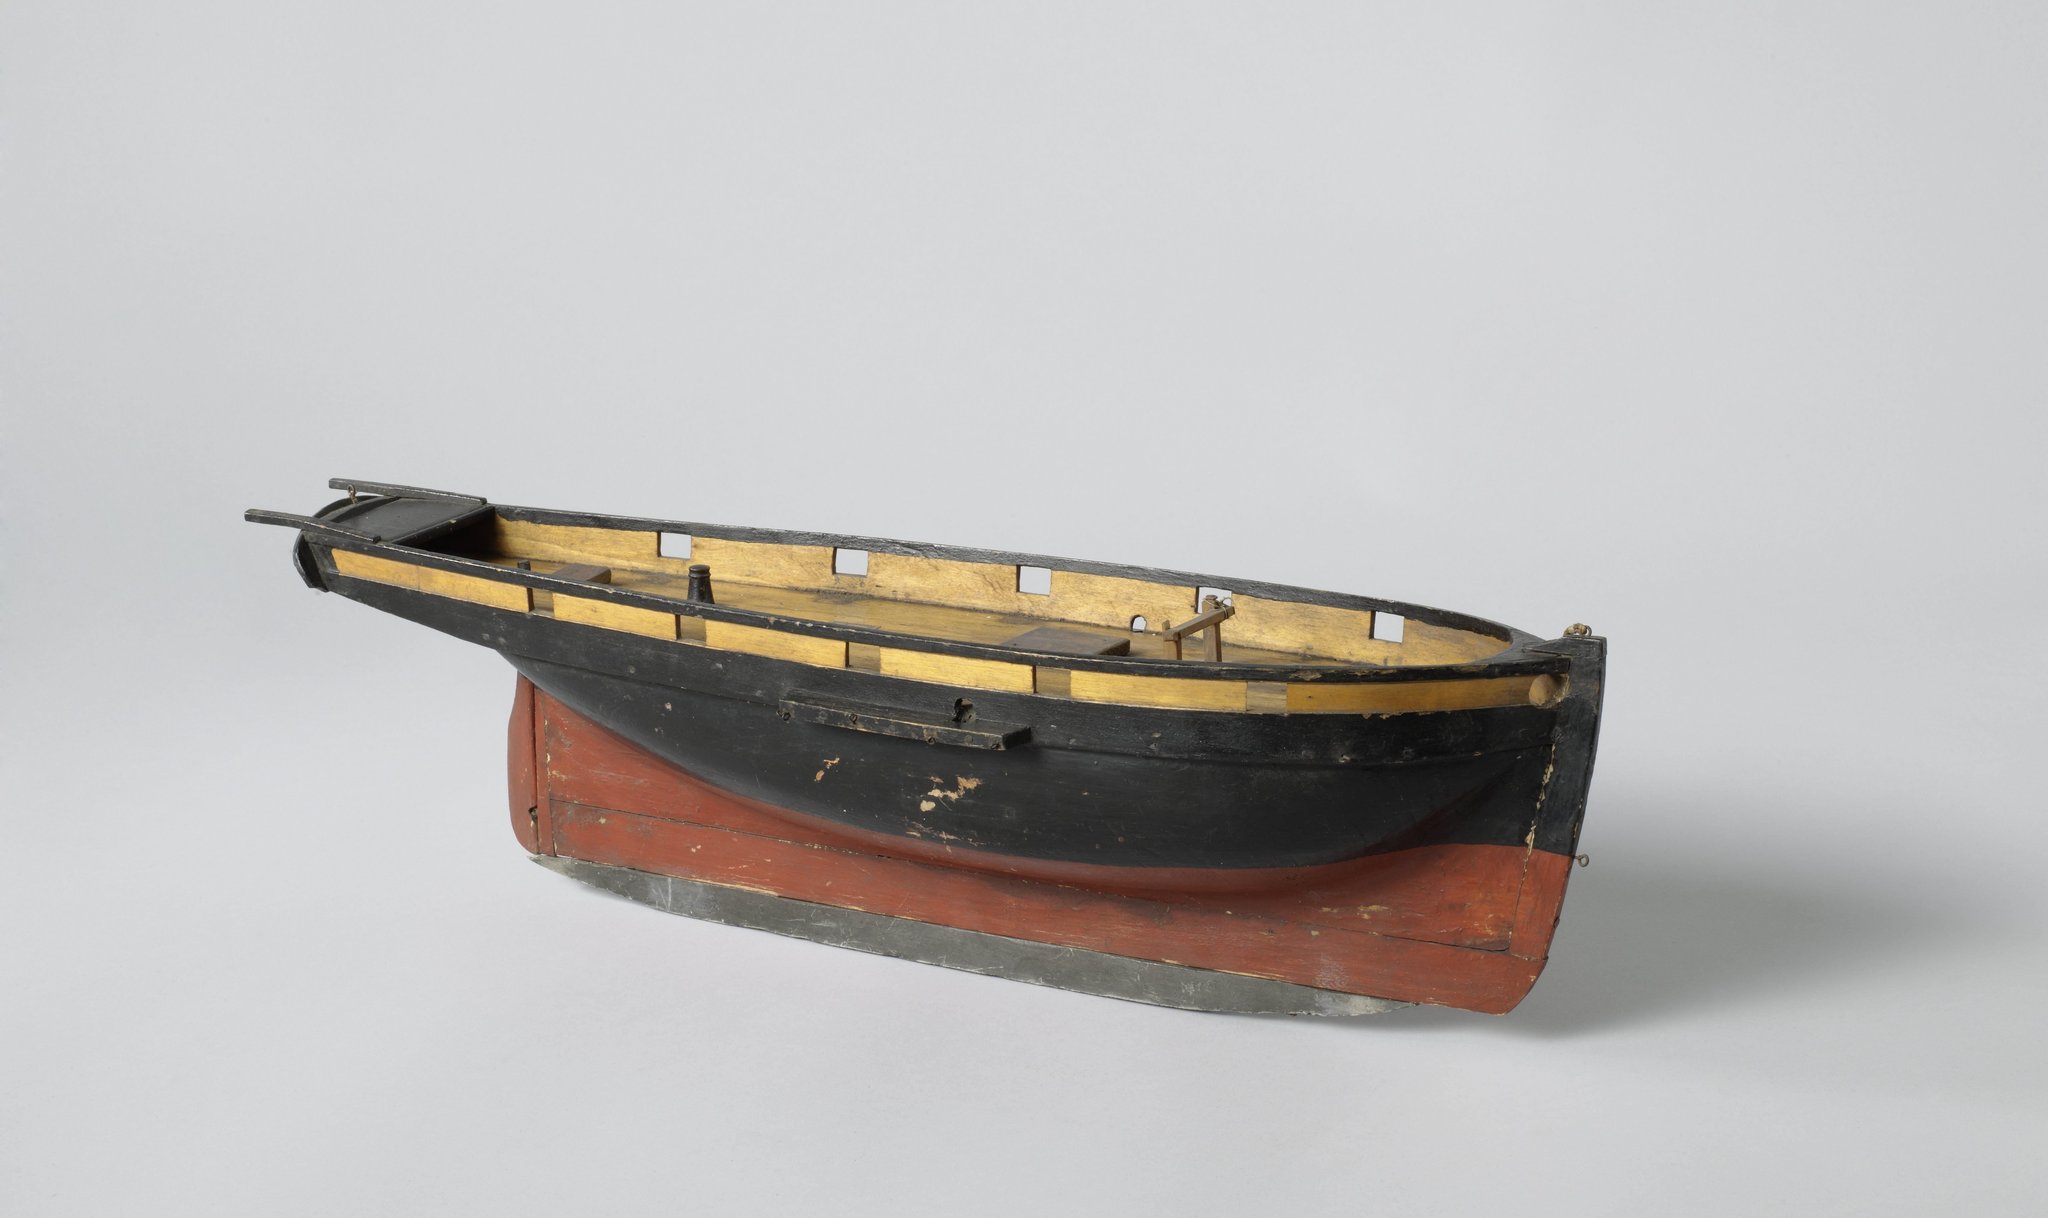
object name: ship model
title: Model of a French Pilot Cutter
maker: Anonymous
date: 1810-1870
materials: wood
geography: france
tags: france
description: Model van een Franse loodskotter, met een verzwaarde kiel.